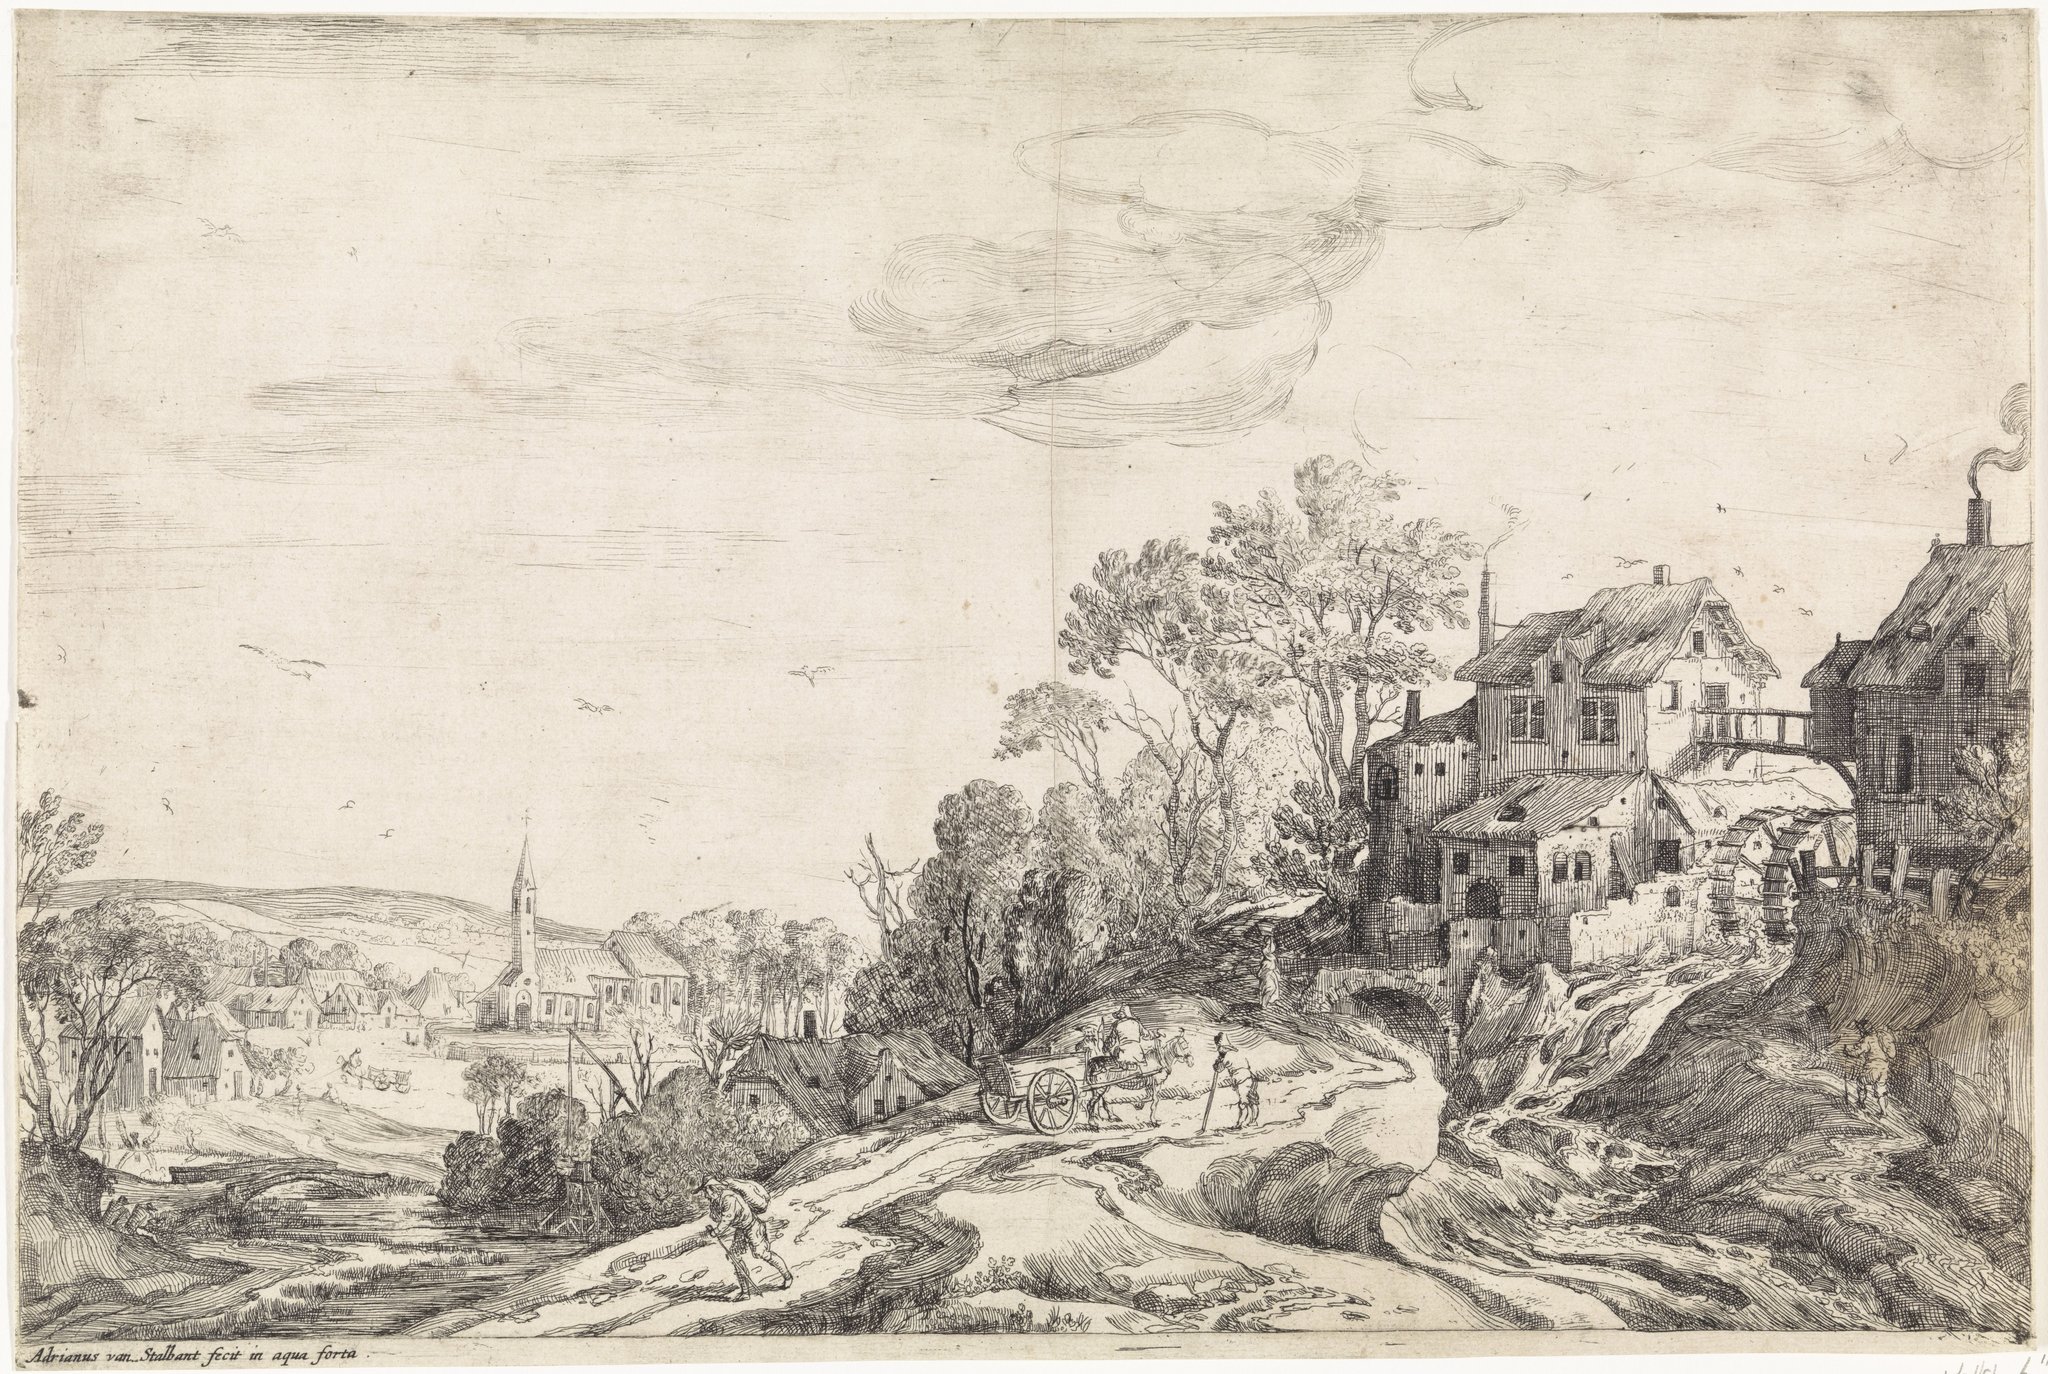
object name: print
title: Landschap met watermolen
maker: adriaen van stalbemt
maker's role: painter, print maker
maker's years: 1580-1662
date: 1590-1662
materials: paper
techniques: etching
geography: antwerp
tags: brook, watermill in landscape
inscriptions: collector's mark: Lugt 240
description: Landschap met rechts op de heuvel een watermolen en huizen. Op de voorgrond enkele wandelaars en een paardenkar. Links op de achtergrond in het dal een dorp en een kerk.